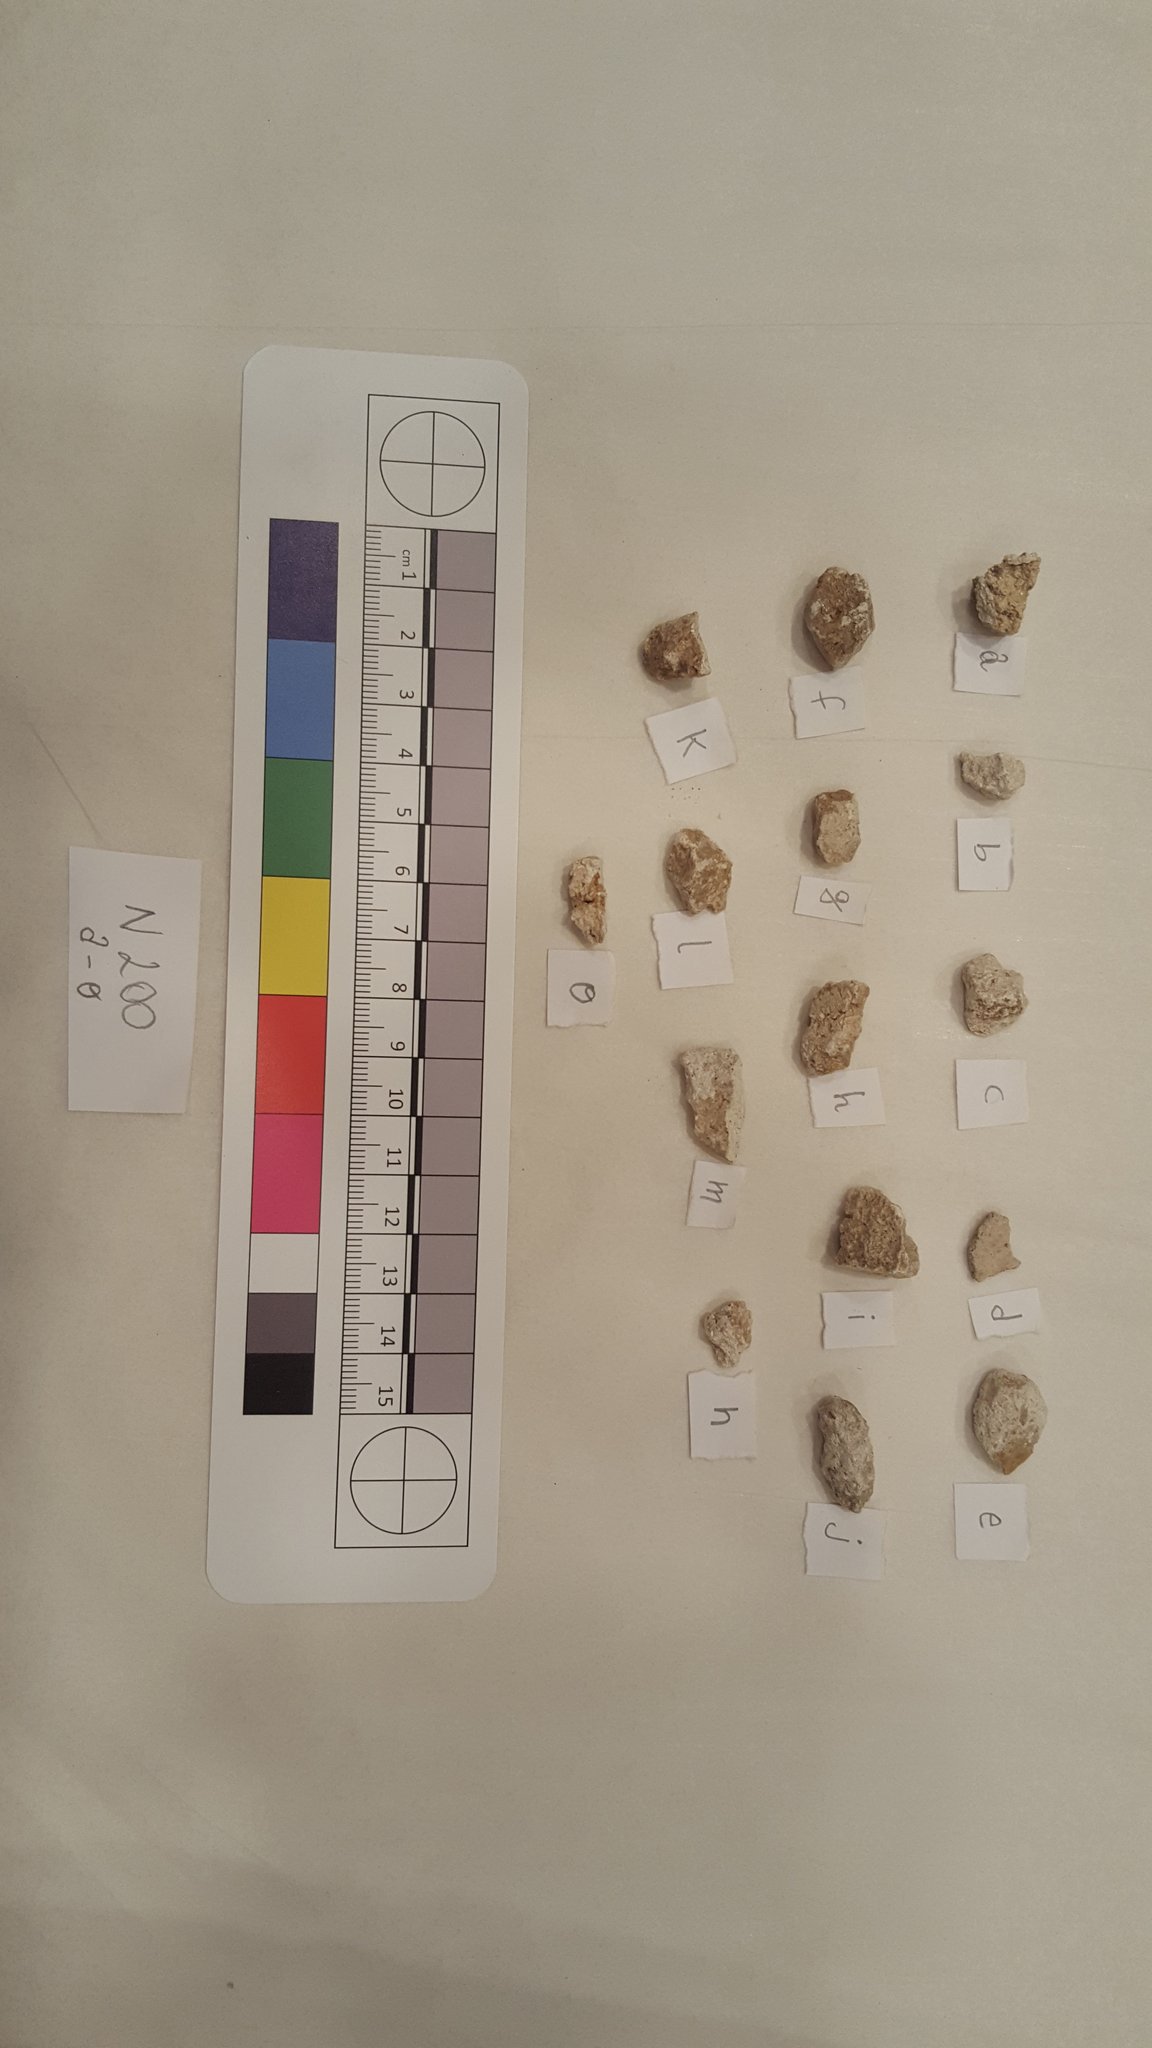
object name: fragment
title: Stucco Fragment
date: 701-1200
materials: plaster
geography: iran